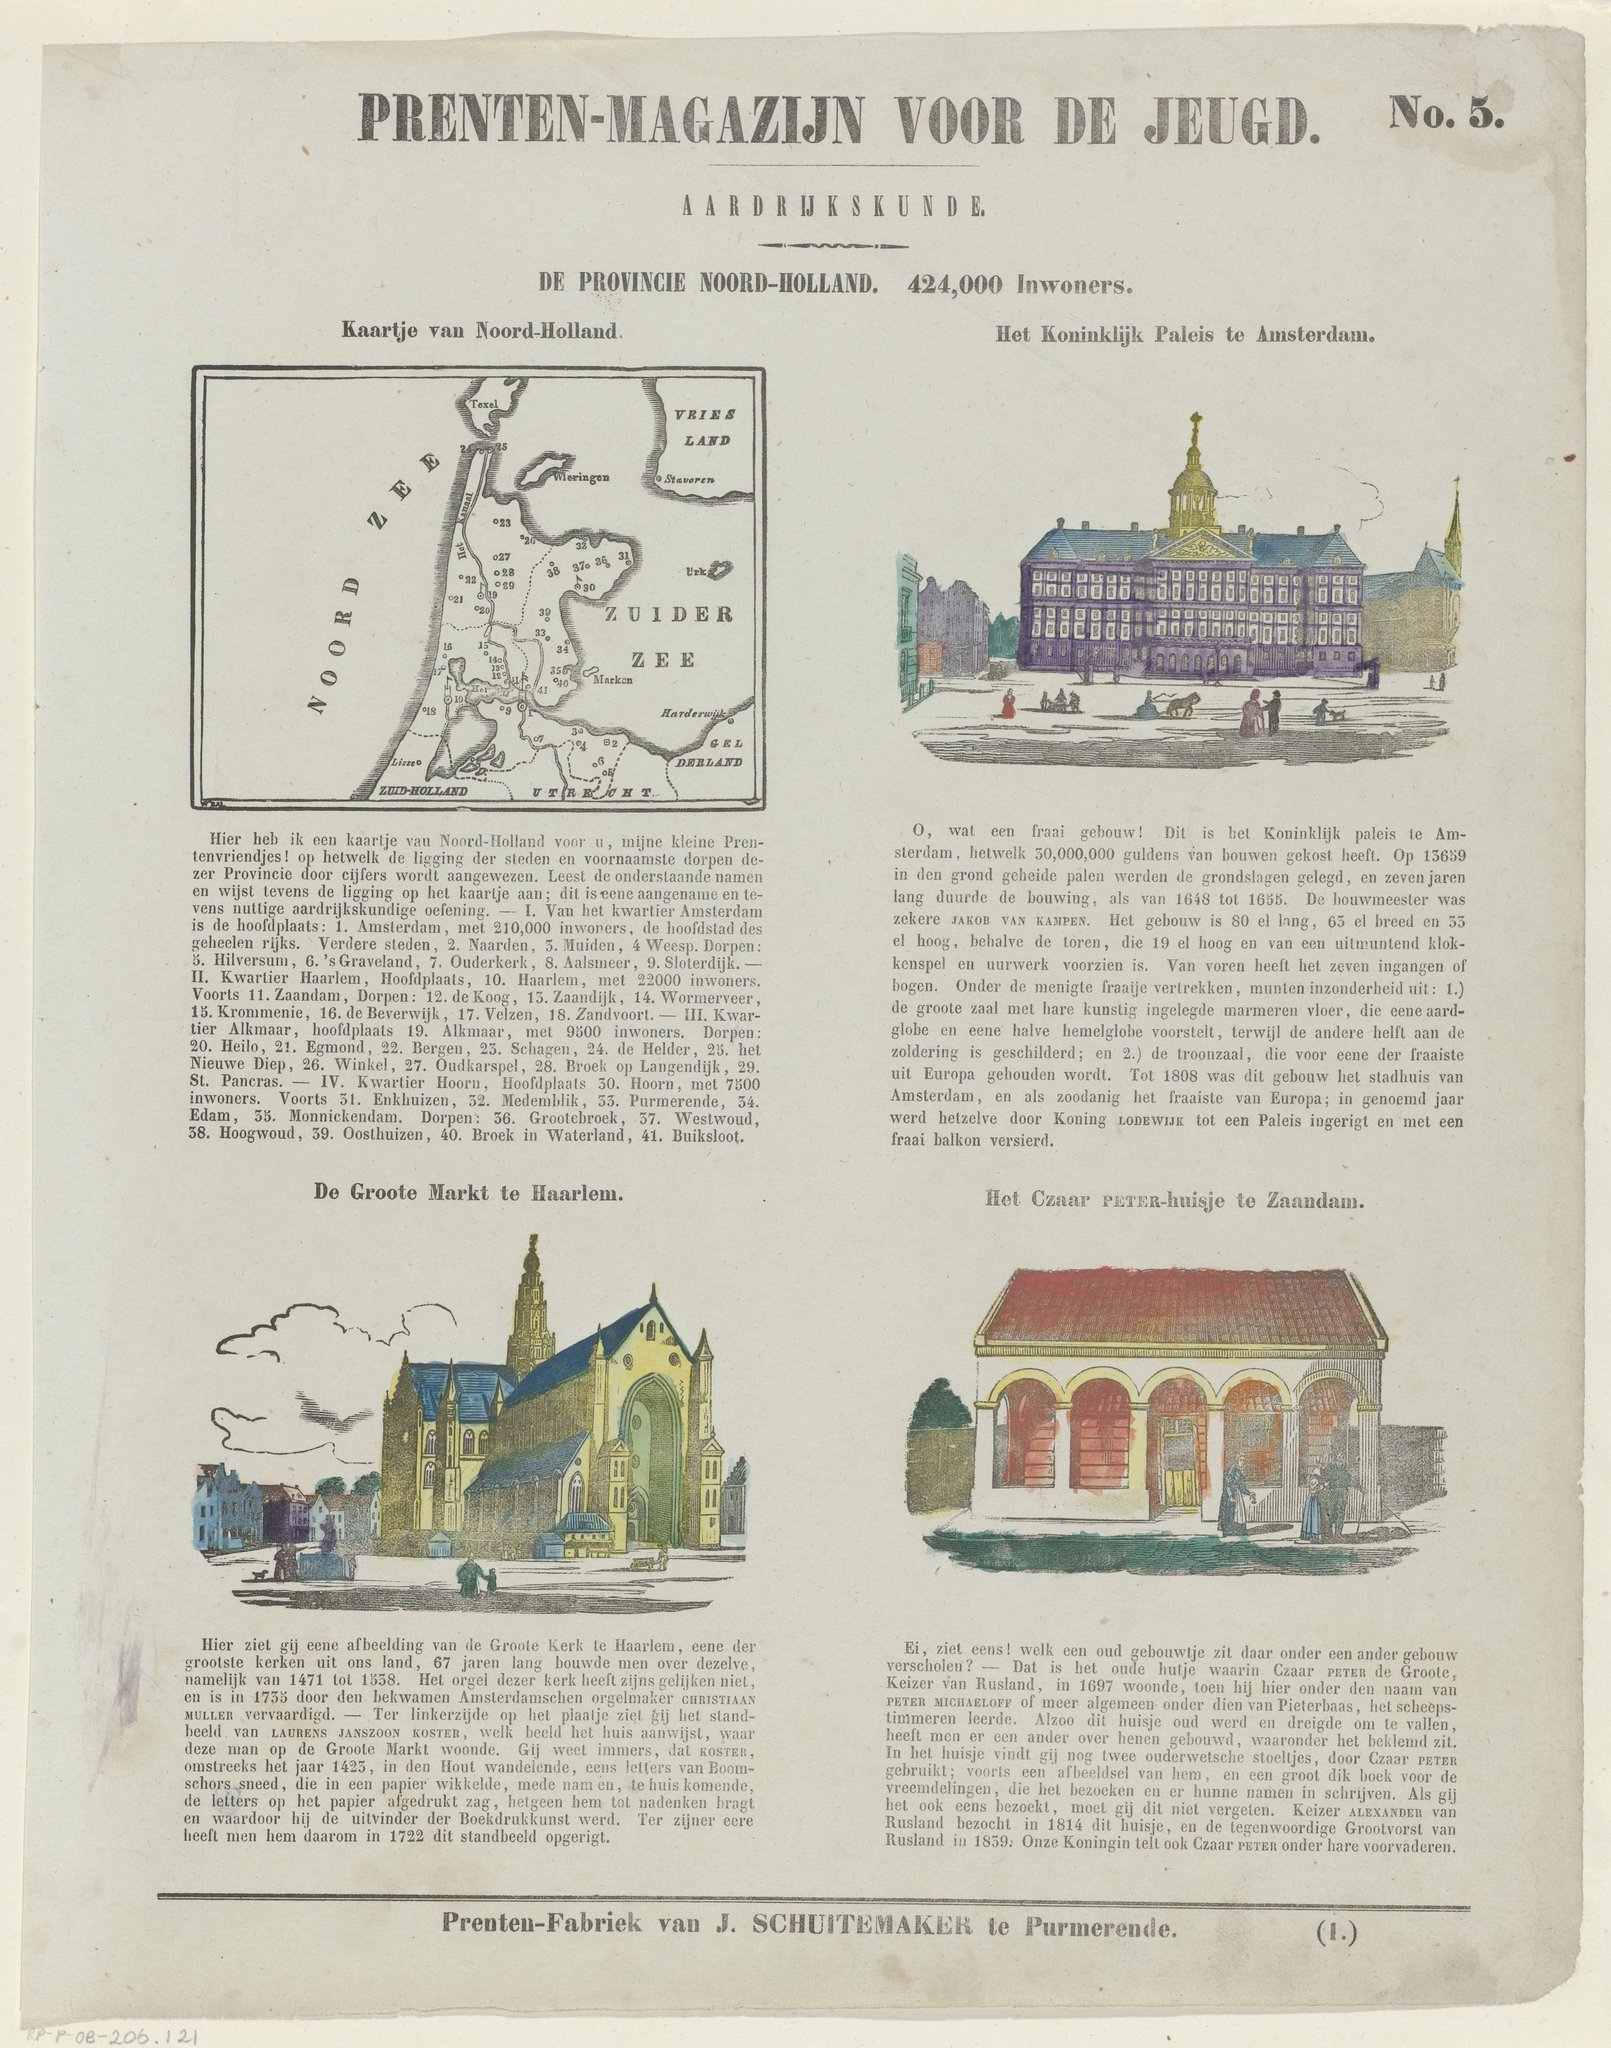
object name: popular print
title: Aardrijkskunde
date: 1850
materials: paper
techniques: colour, letterpress printing, engraving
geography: netherlands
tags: maps, atlases, palace, roman catholic church, royal palace of amsterdam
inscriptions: collector's mark: Lugt 2760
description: Na voltooiing van de acht jaargangen van de reeks 'Prenten-magazijn voor de jeugd' in 1850 heeft Jan Schuitemaker al deze prenten heruitgegeven en omgenummerd als nr. 1 t/m 192. De oorspronkelijke jaargang wordt telkens nog vermeld rechtsonder op de prent. Binnen de jaargangen zijn prenten van hetzelfde thema in clusters van vier achter elkaar gezet.